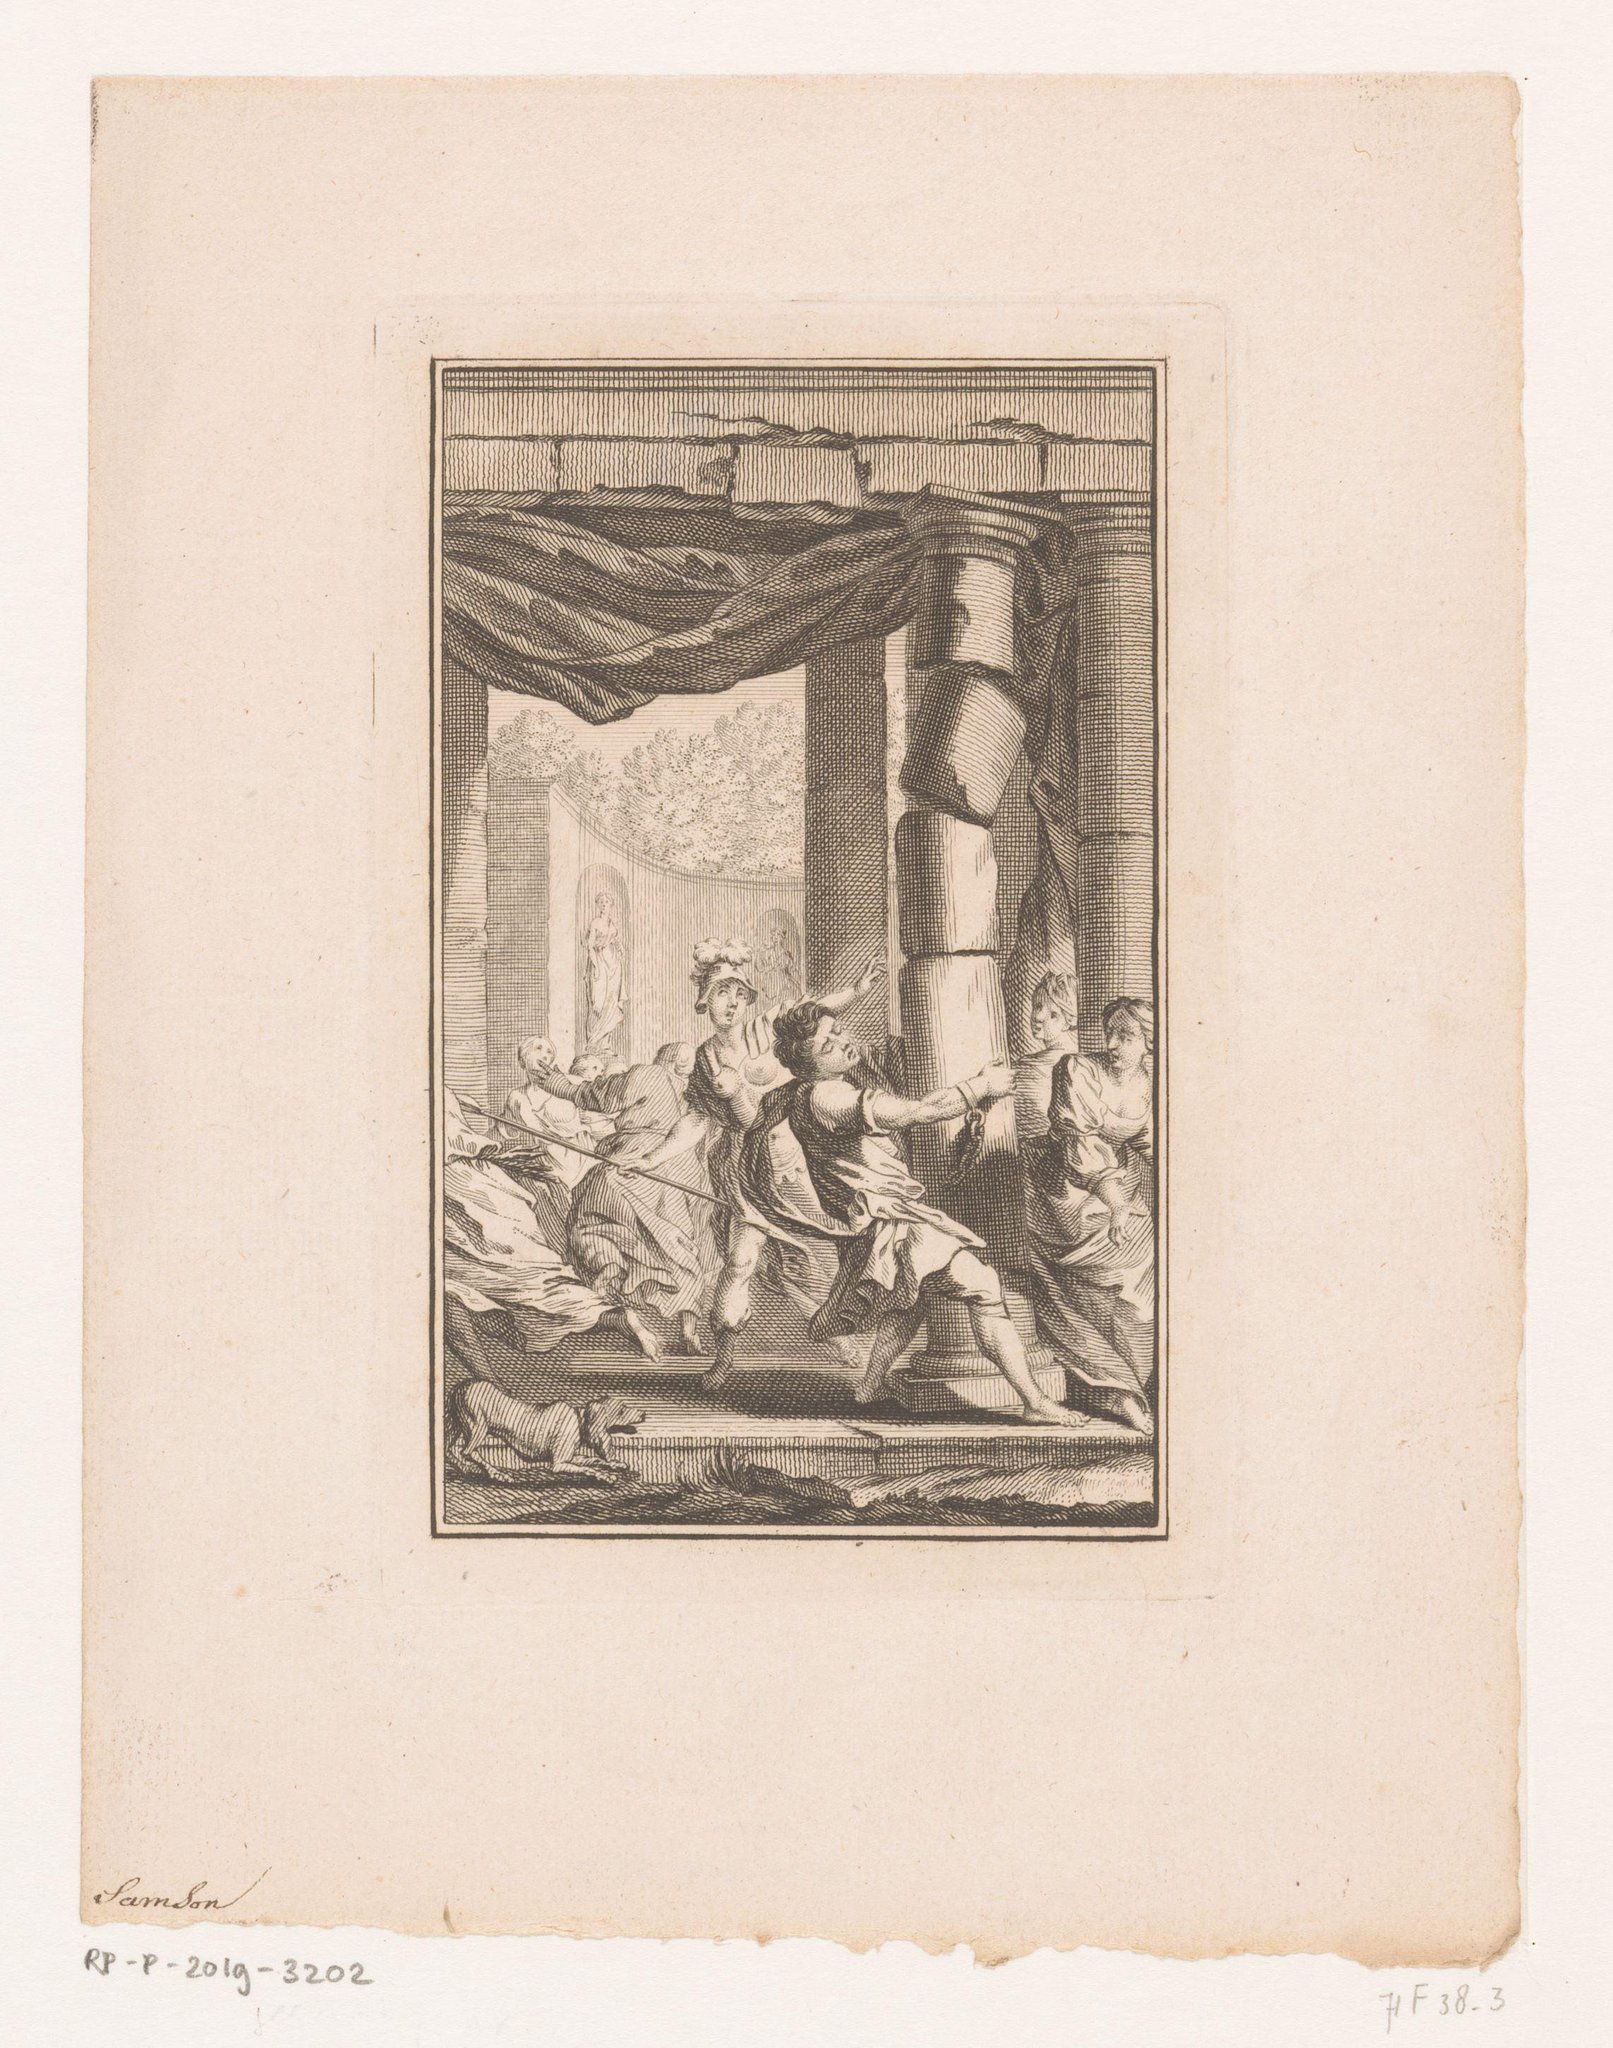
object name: print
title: Simson verwoest de tempel van de Filistijnen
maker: Anonymous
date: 1650-1750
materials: paper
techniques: engraving, etching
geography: netherlands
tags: samson breaks the pillars; the temple of dagon collapses, killing all that are in it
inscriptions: inscription: ‘Samson’, collector's mark: Lugt 2228